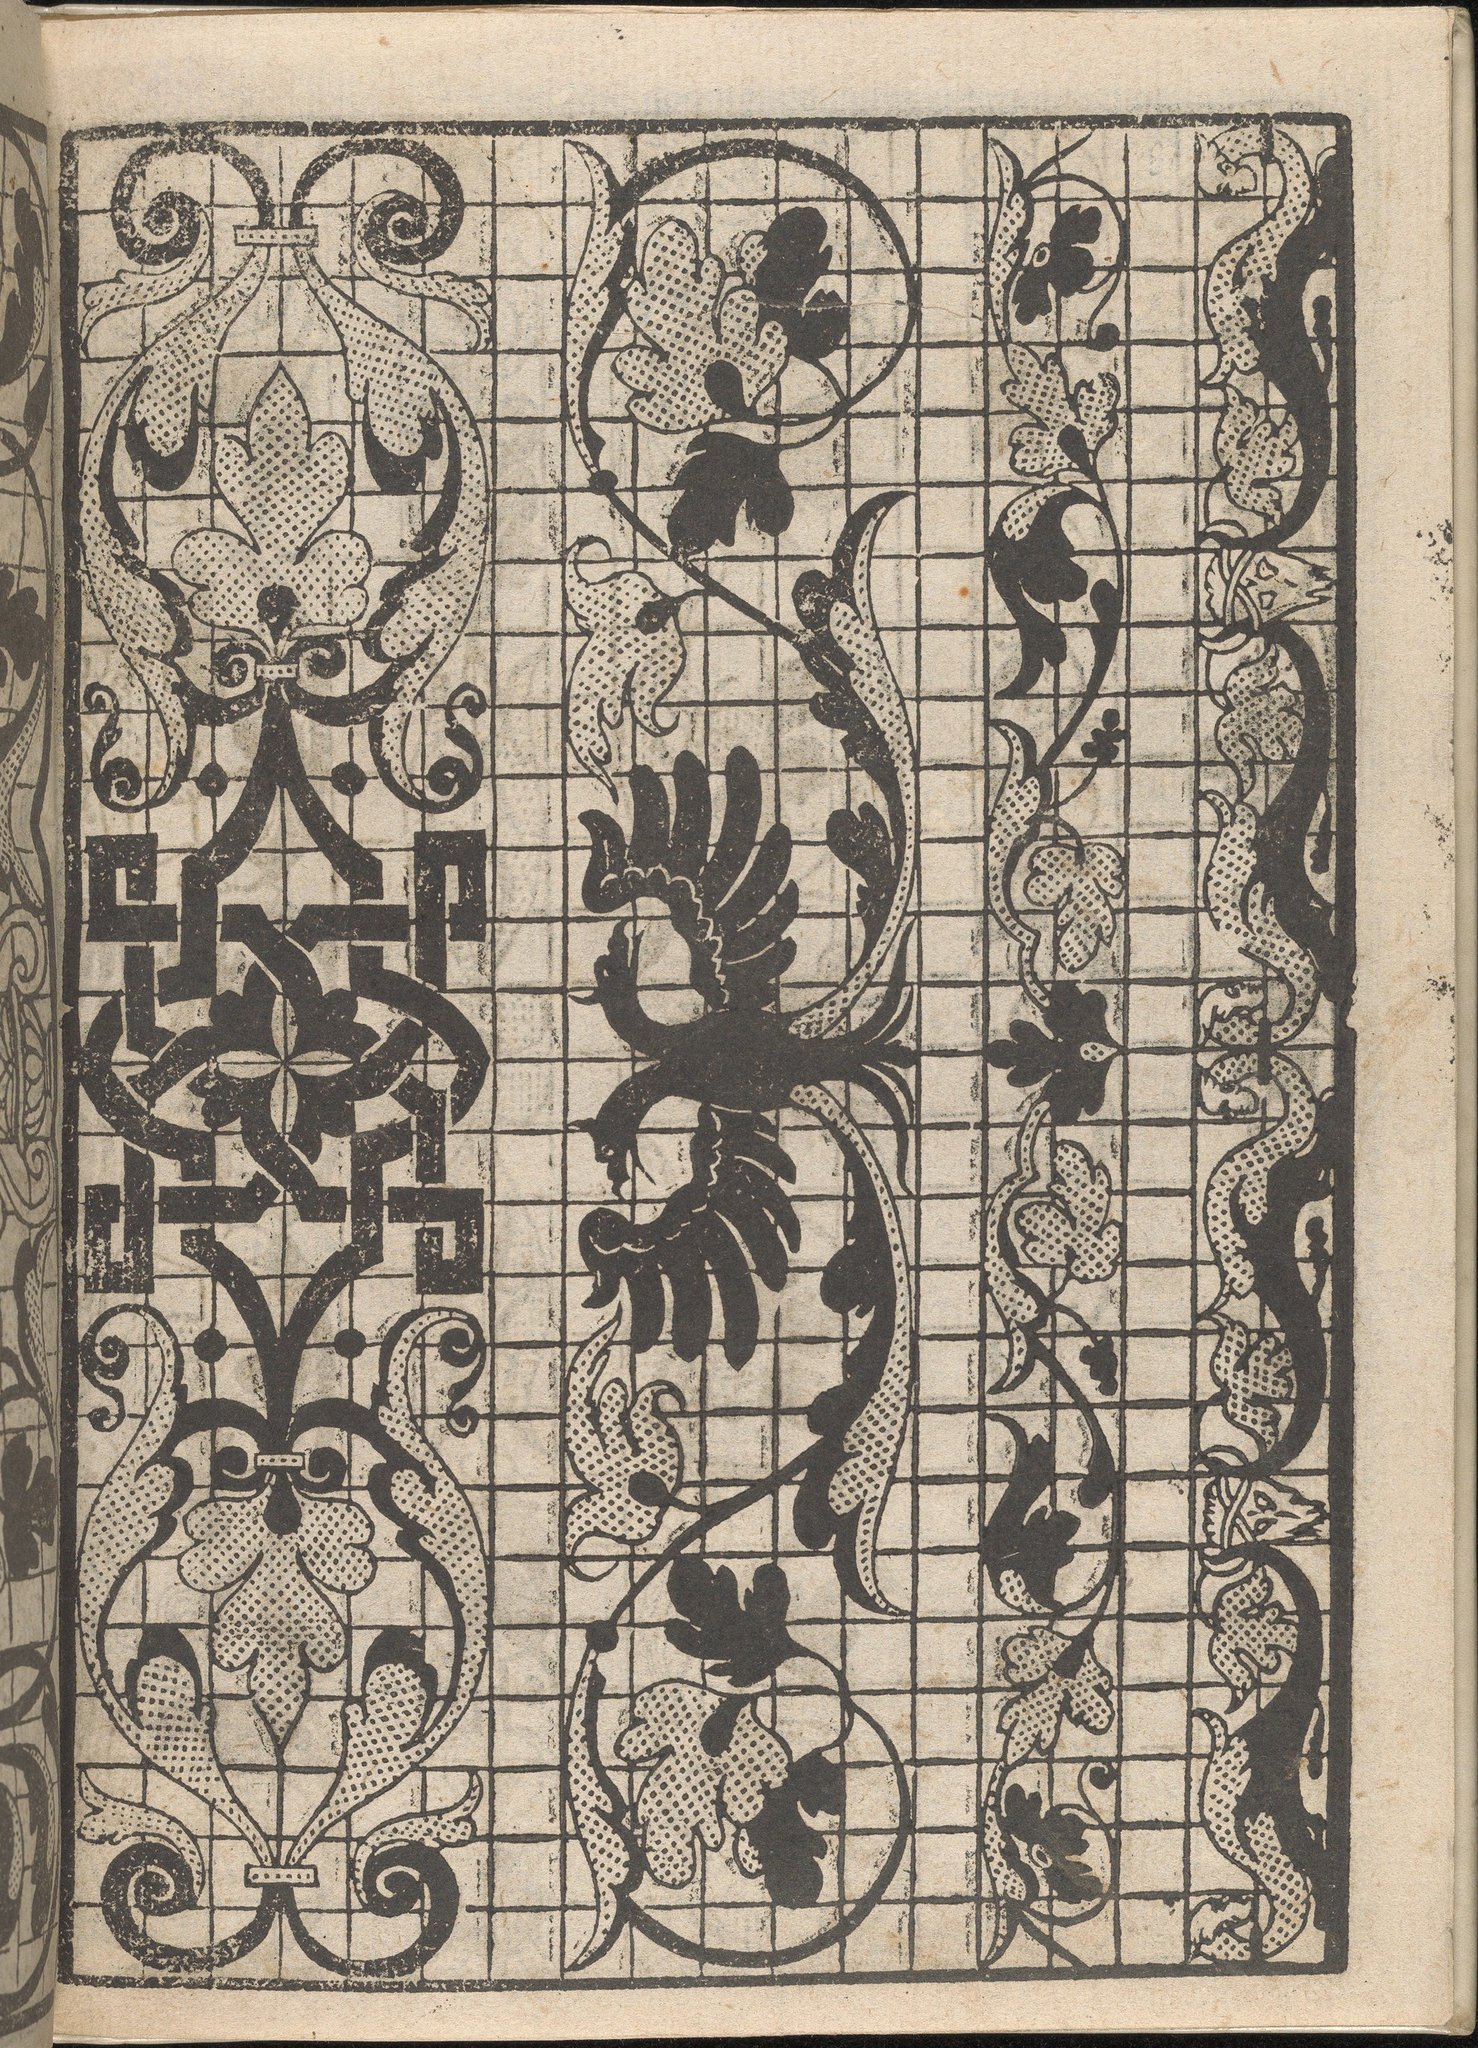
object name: book print ornament architecture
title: Splendore delle virtuose giovani, page 8 (recto)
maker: iseppo foresto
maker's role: designer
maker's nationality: italian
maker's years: 1520-1580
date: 1564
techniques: woodcut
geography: italy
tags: ornament